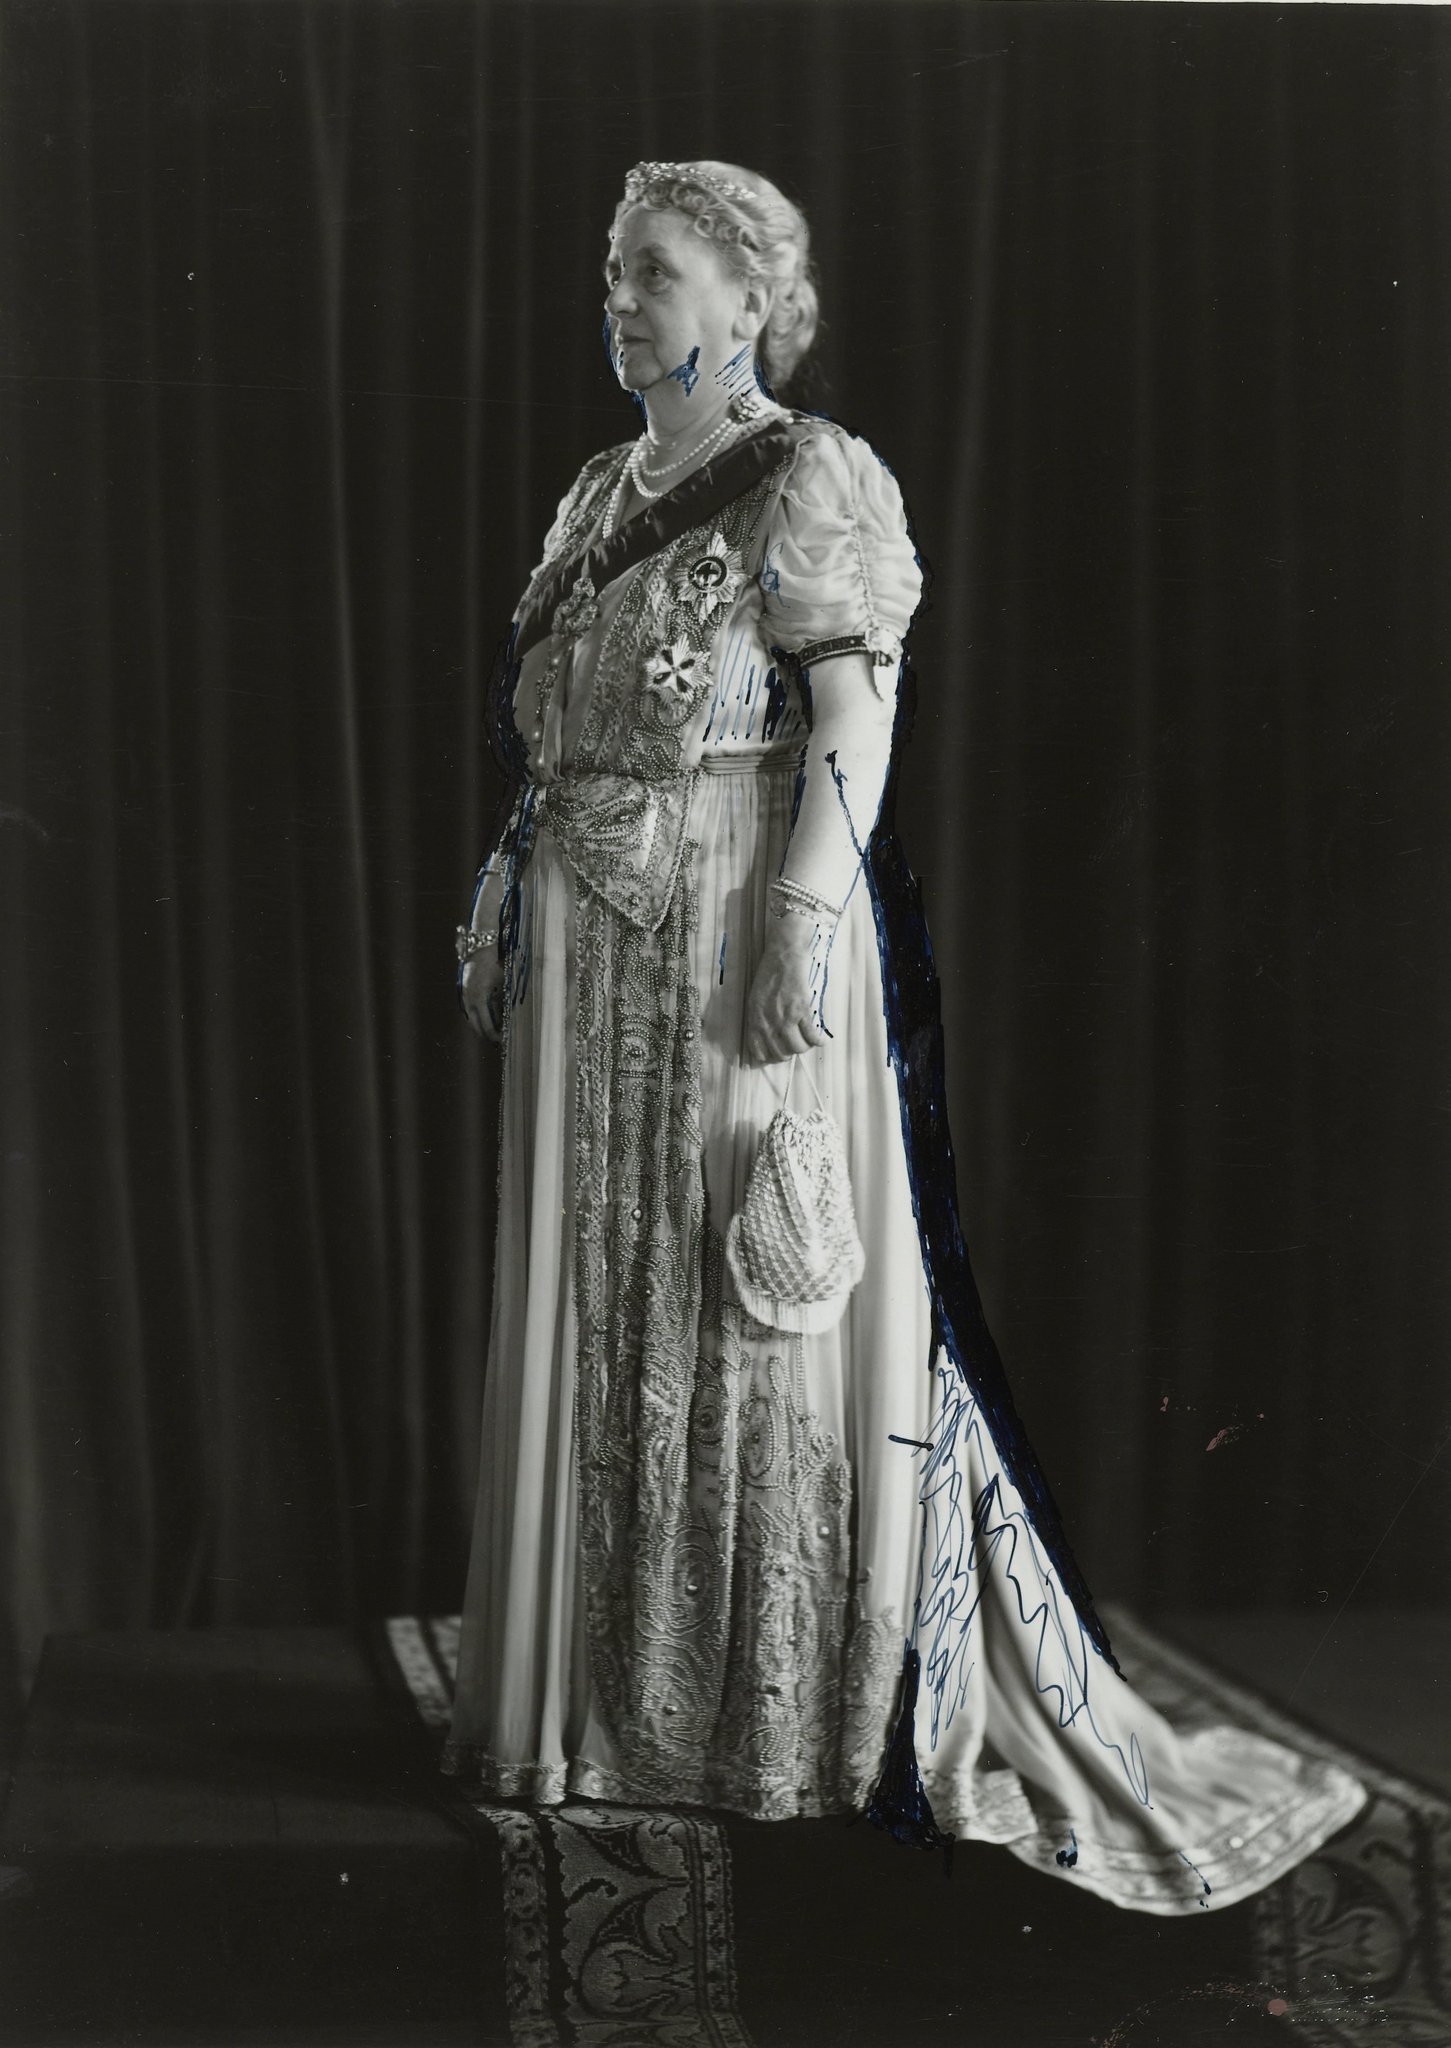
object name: photograph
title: Koningin Wilhelmina poseert met de Willemsorde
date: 1948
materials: photographic support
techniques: photography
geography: amsterdam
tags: the hague, print maker, wilhelmina of the netherlands, amsterdam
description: Koningin Wilhelmina poseert met de Willemsorde. Portret staand, ten voeten uit.